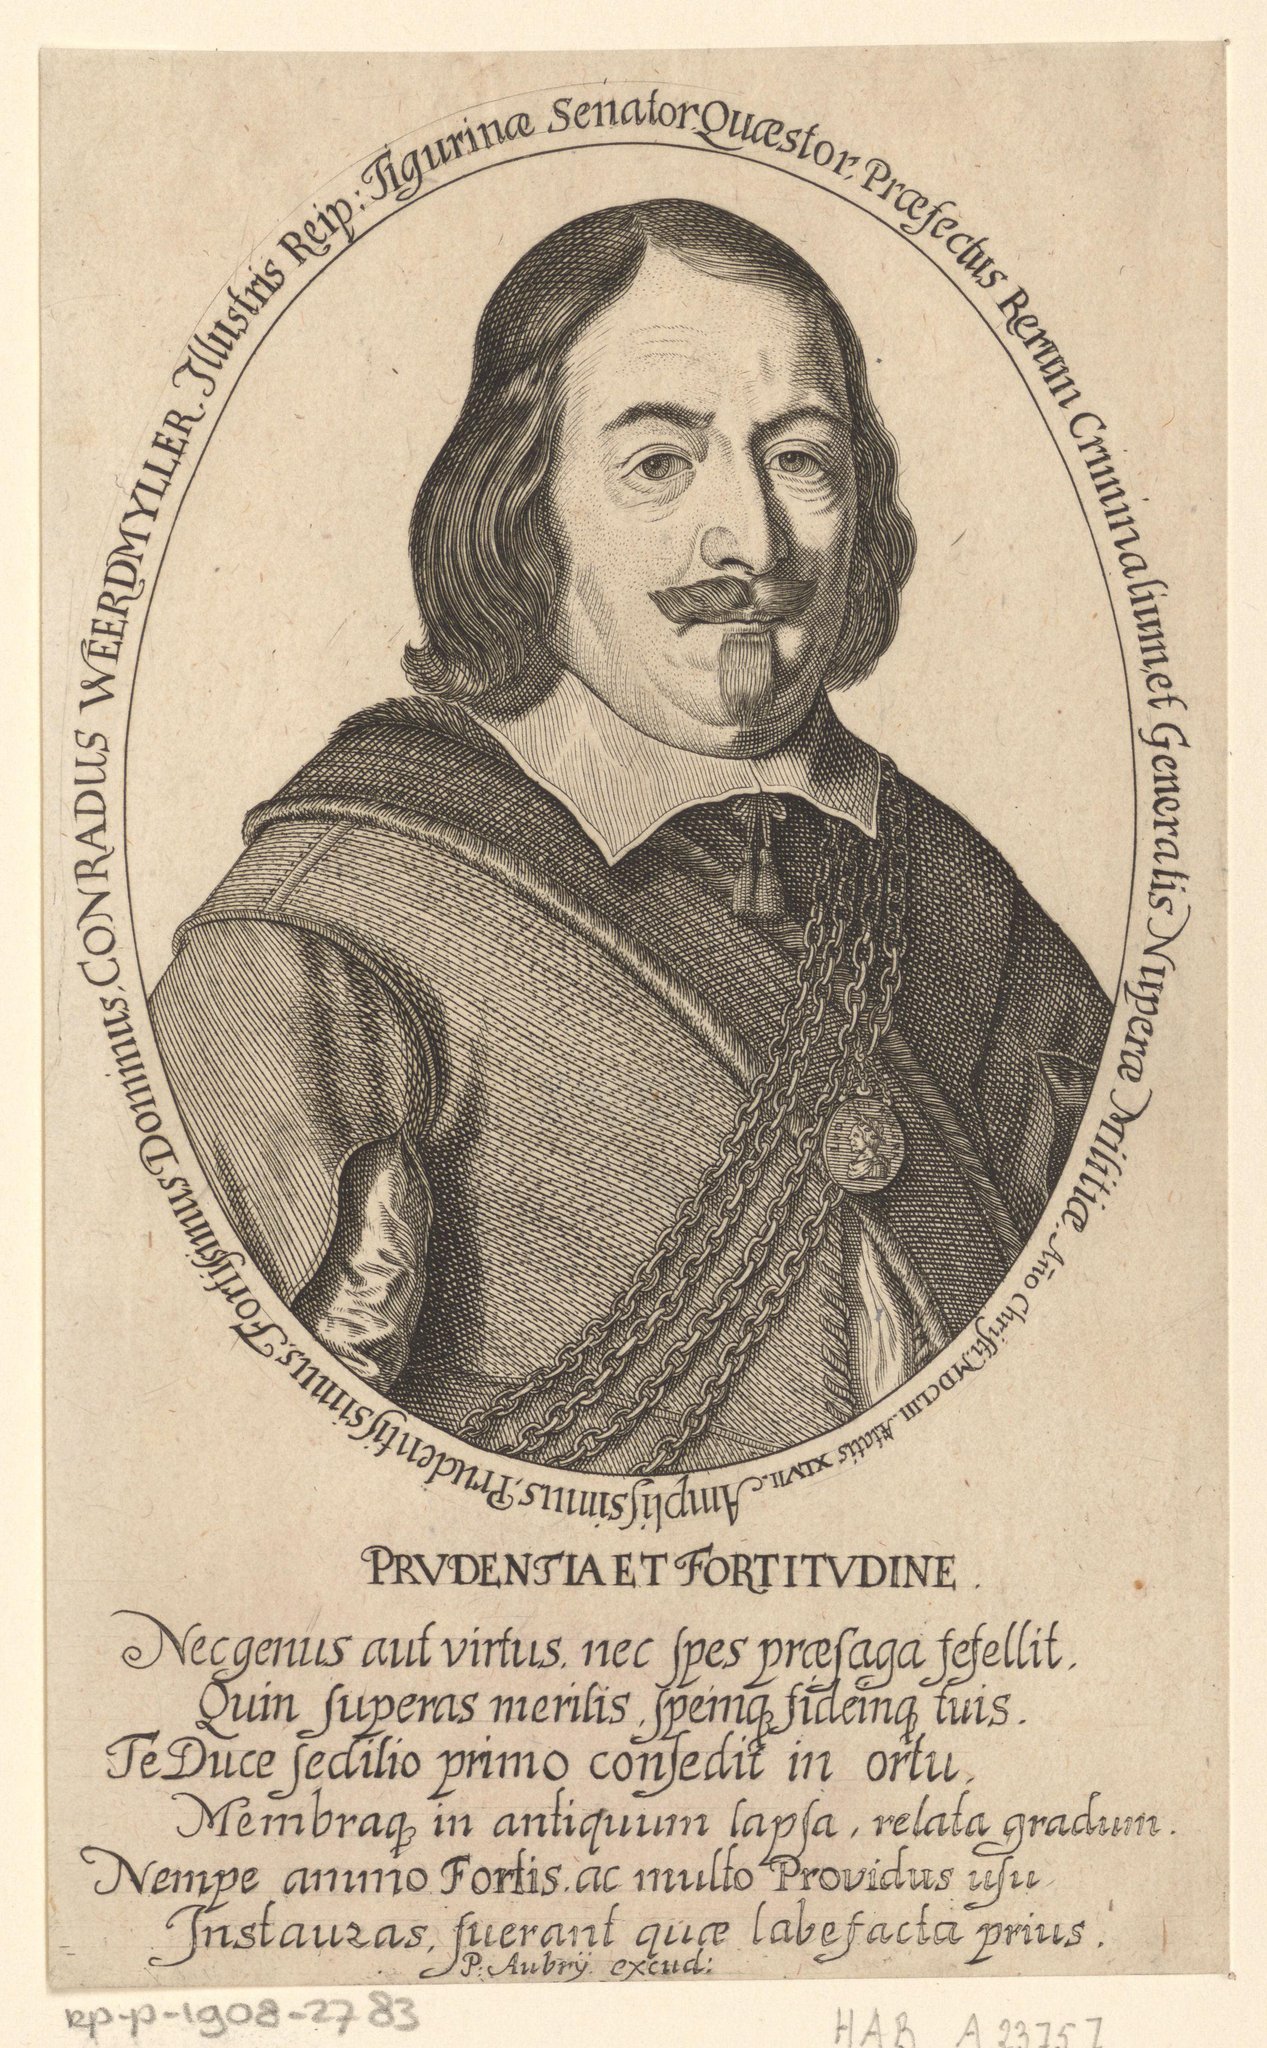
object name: print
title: Portret van Hans Conrad Werdmüller op 47-jarige leeftijd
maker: peter aubry (ii)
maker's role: print maker, publisher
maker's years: 1596-1668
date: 1653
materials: paper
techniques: engraving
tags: mayor, mayor, burgomaster, historical persons, pendant, trinket, 'breloque'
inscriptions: collector's mark: Lugt 2228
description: Met zesregelig onderschrift in het Latijn.